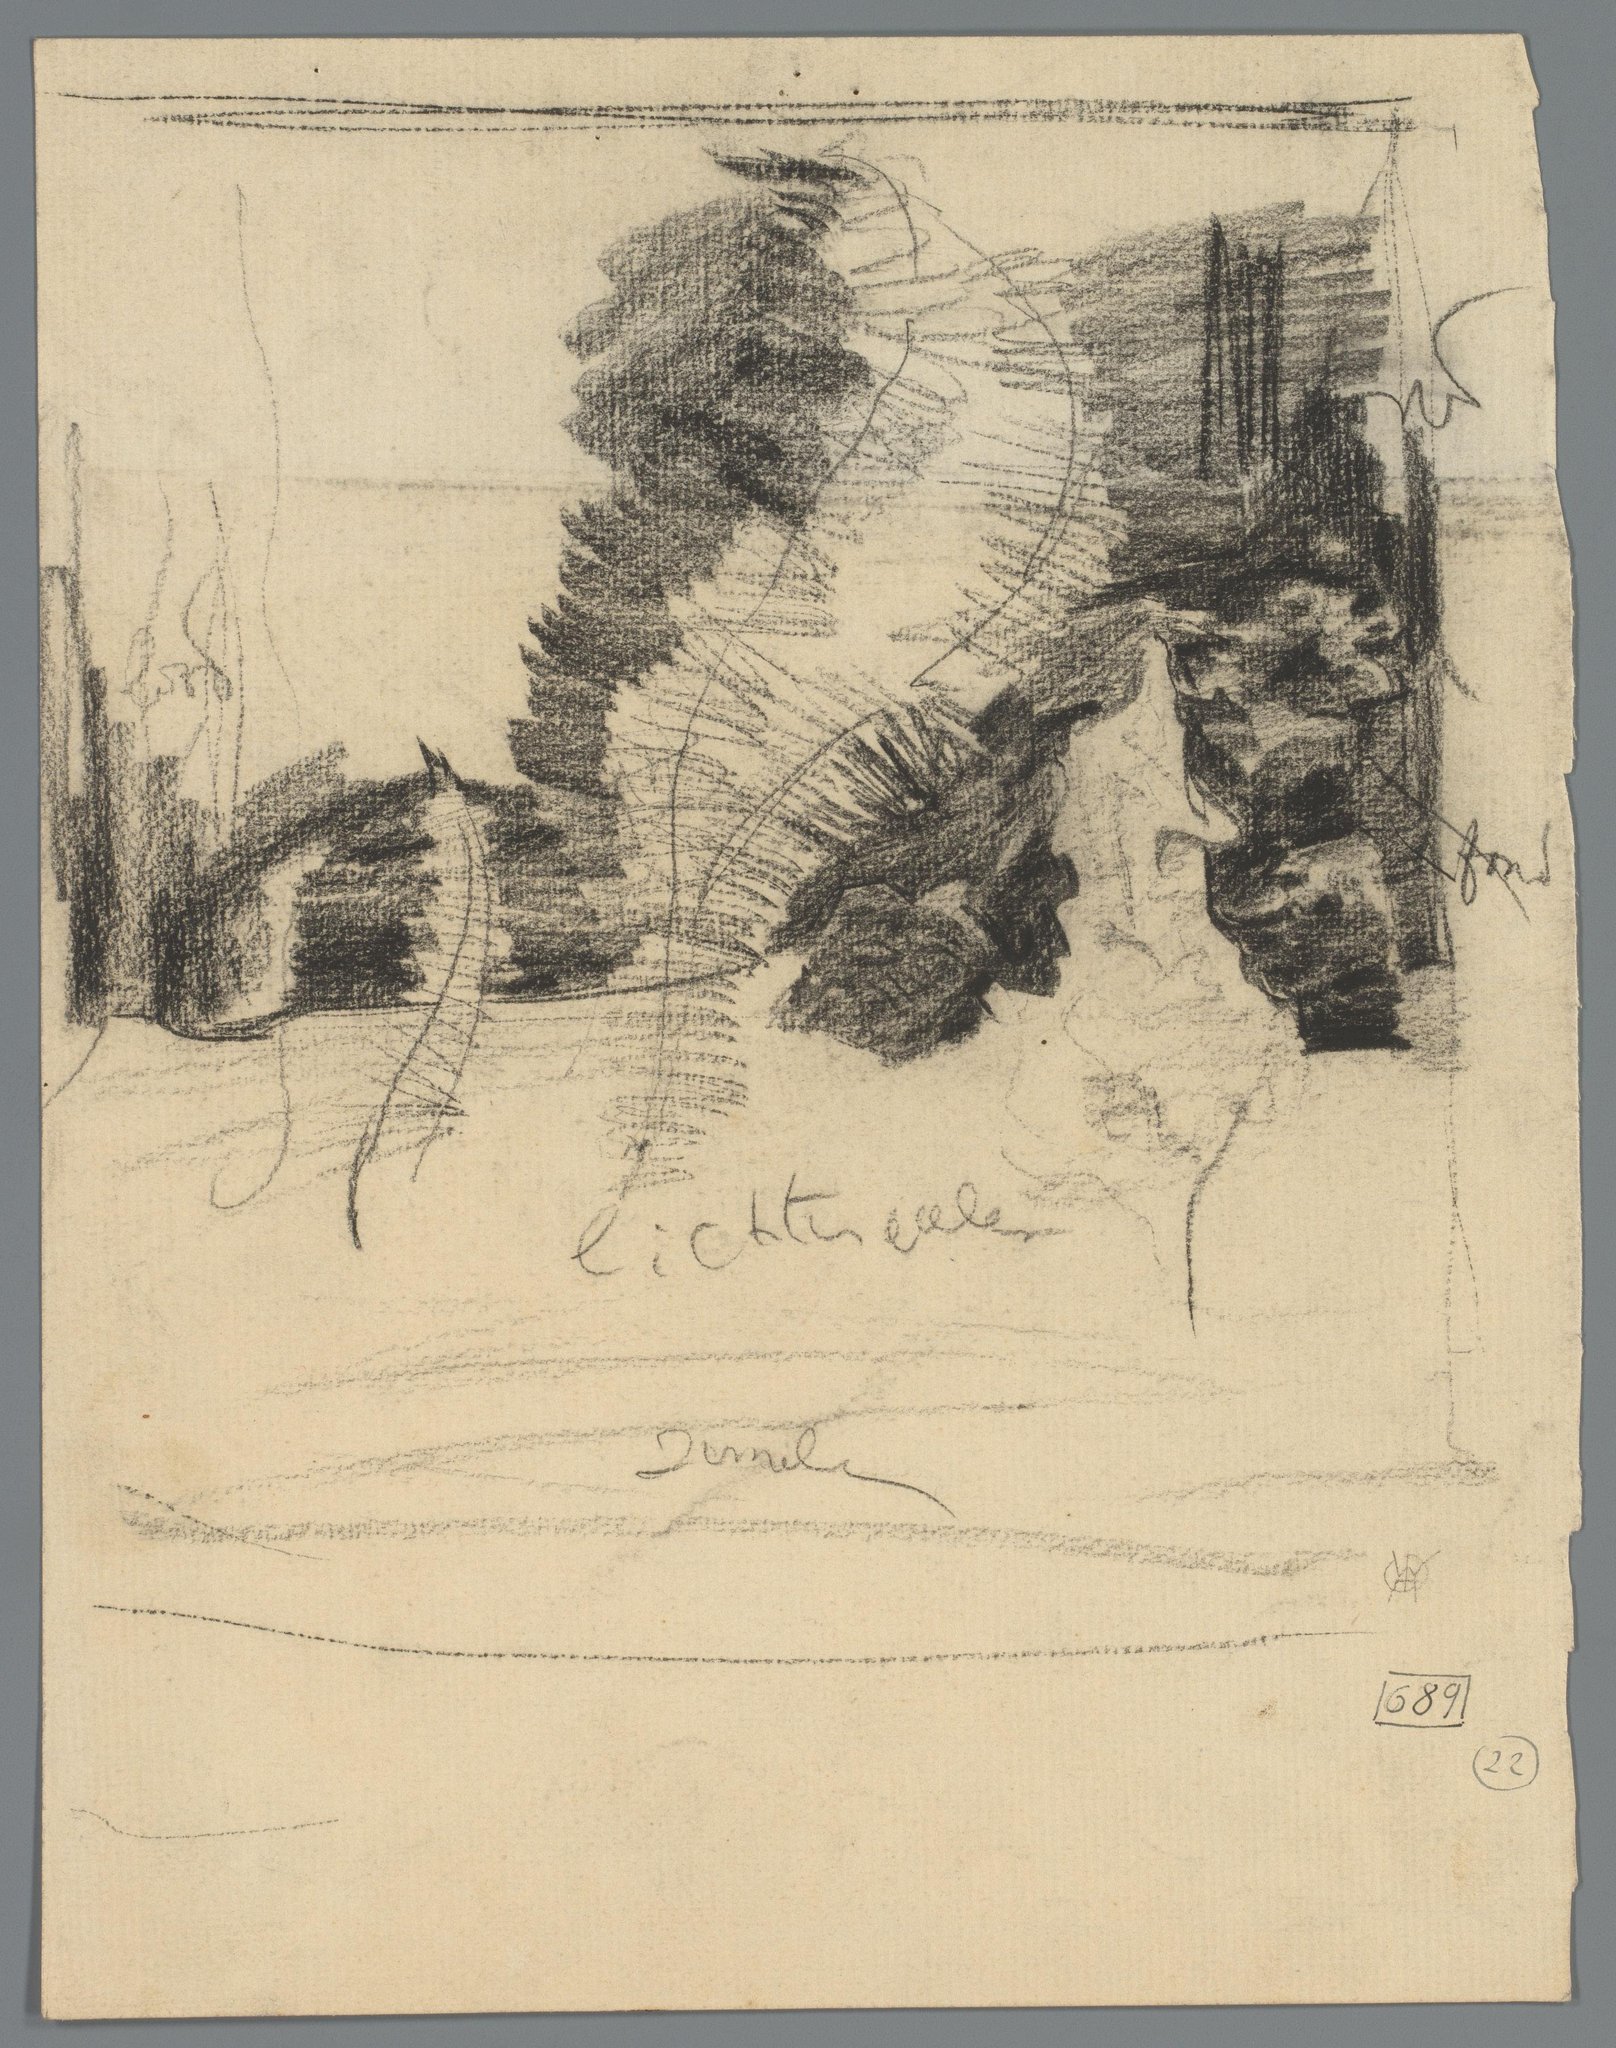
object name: drawing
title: Studie van een aquarium met waterplanten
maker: gerrit willem dijsselhof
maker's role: designer, draughtsman, print maker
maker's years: 1866-1924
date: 1876-1924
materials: chalk, paper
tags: plants (in general), aquarium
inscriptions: number: ‘689’, number: ‘22’